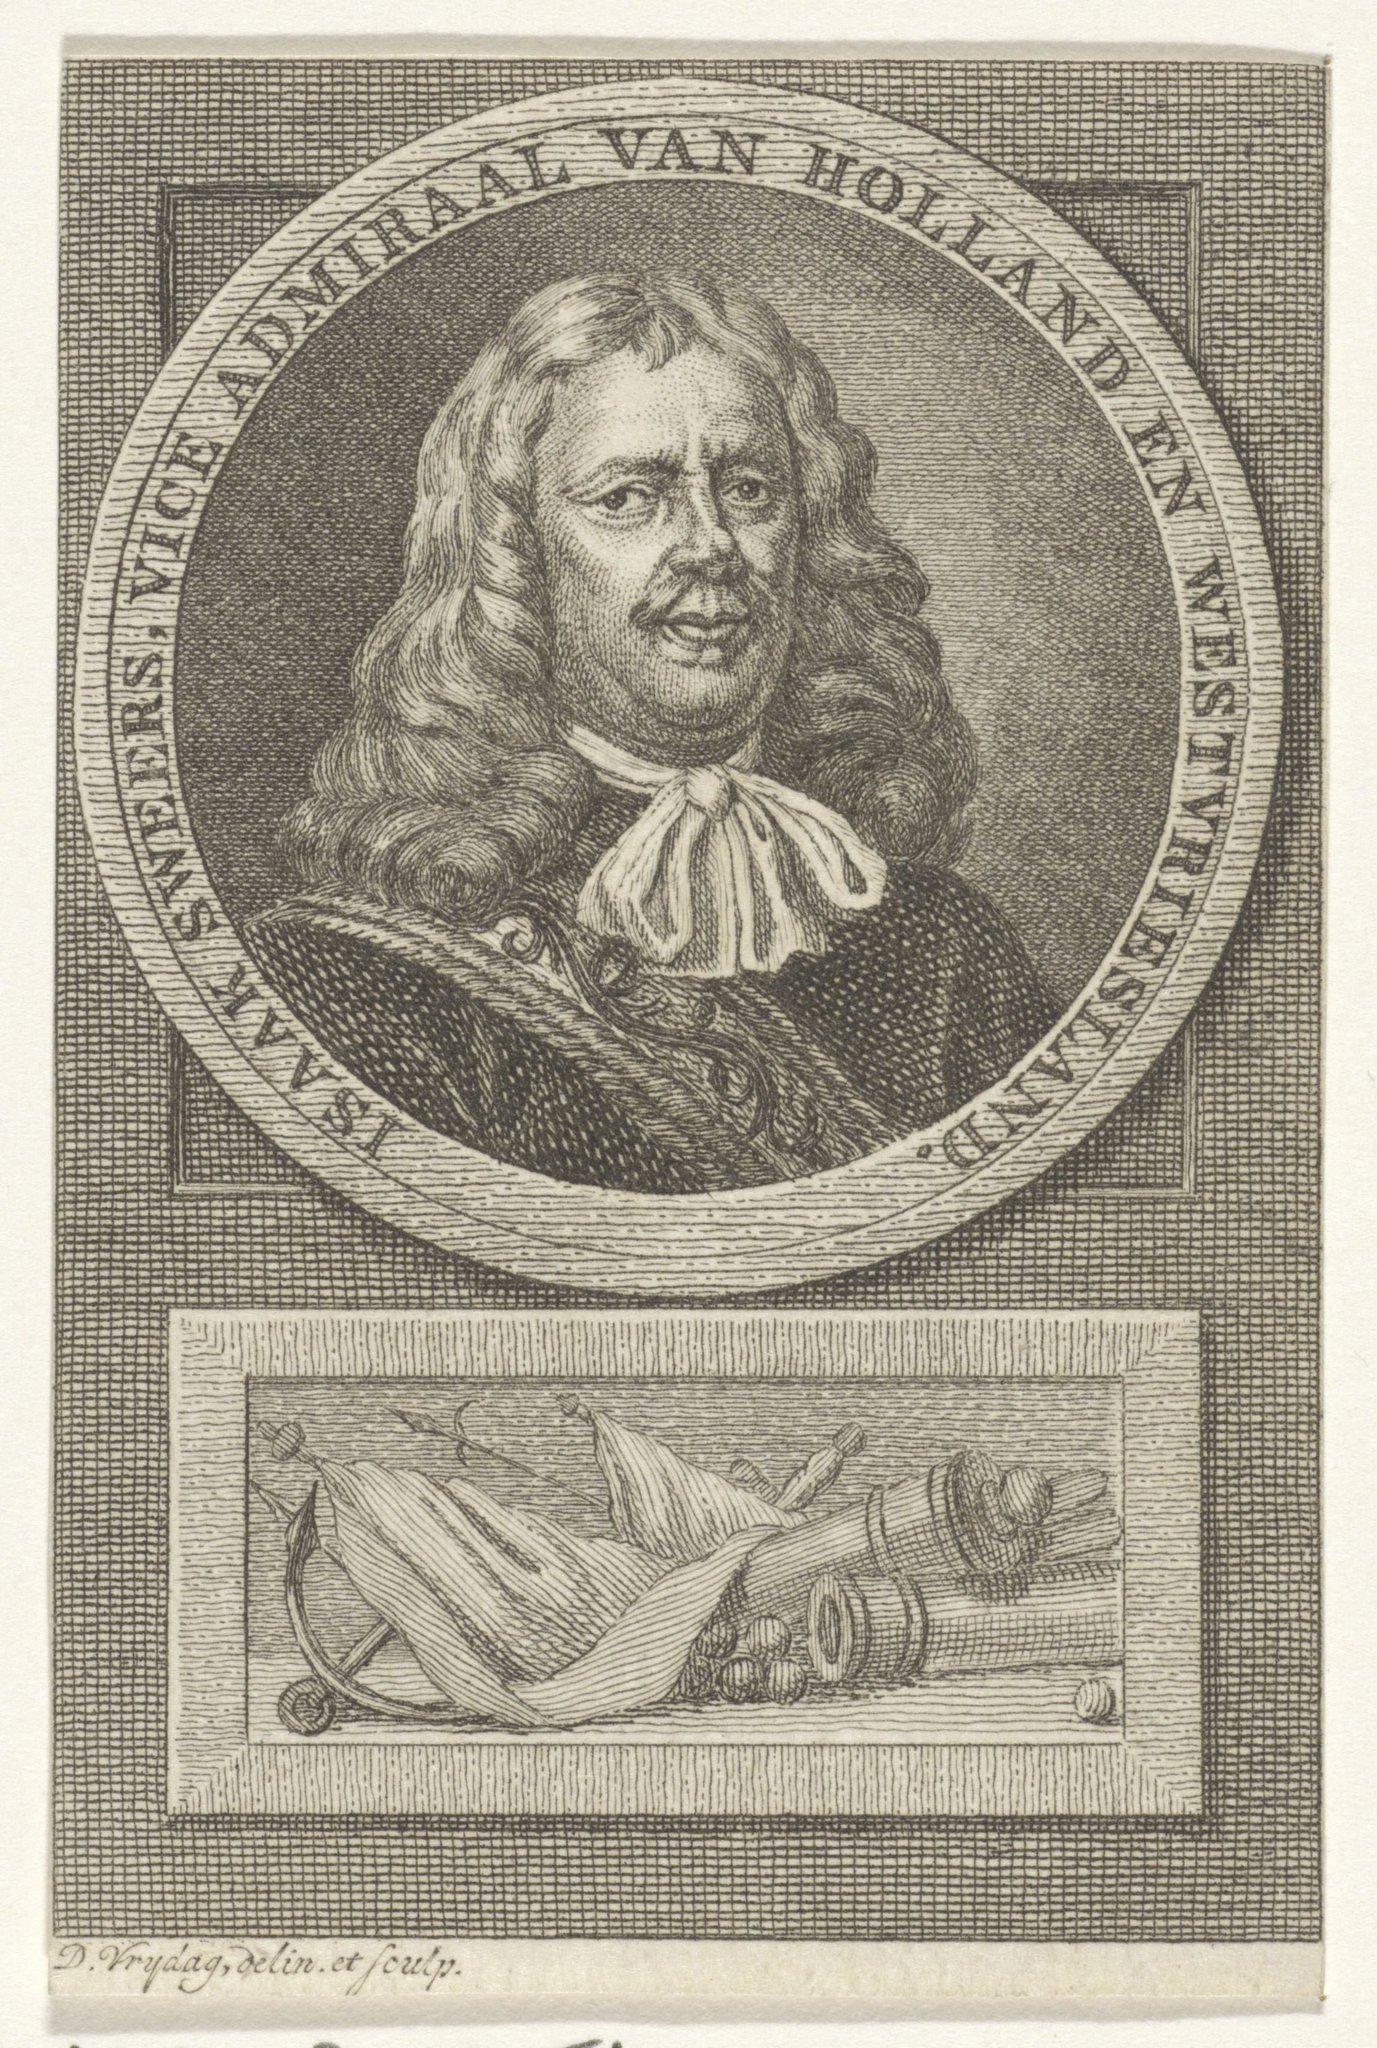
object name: print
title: Portret van Isaac Sweers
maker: daniël vrijdag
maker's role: draughtsman, print maker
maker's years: 1765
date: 1783-1795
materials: paper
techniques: engraving, etching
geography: amsterdam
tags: nijmegen, firearms: cannon, parts of ship's exterior: anchor, (military) flags and standards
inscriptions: collector's mark: Lugt 2228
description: Prent gebruikt in: Fokke, Jan. Geschiedenissen der Vereenigde Nederlanden voor de vaderlandsche jeugd Ie-XXVste deel. Amsterdam: Johannes Allart, 1783-1795.